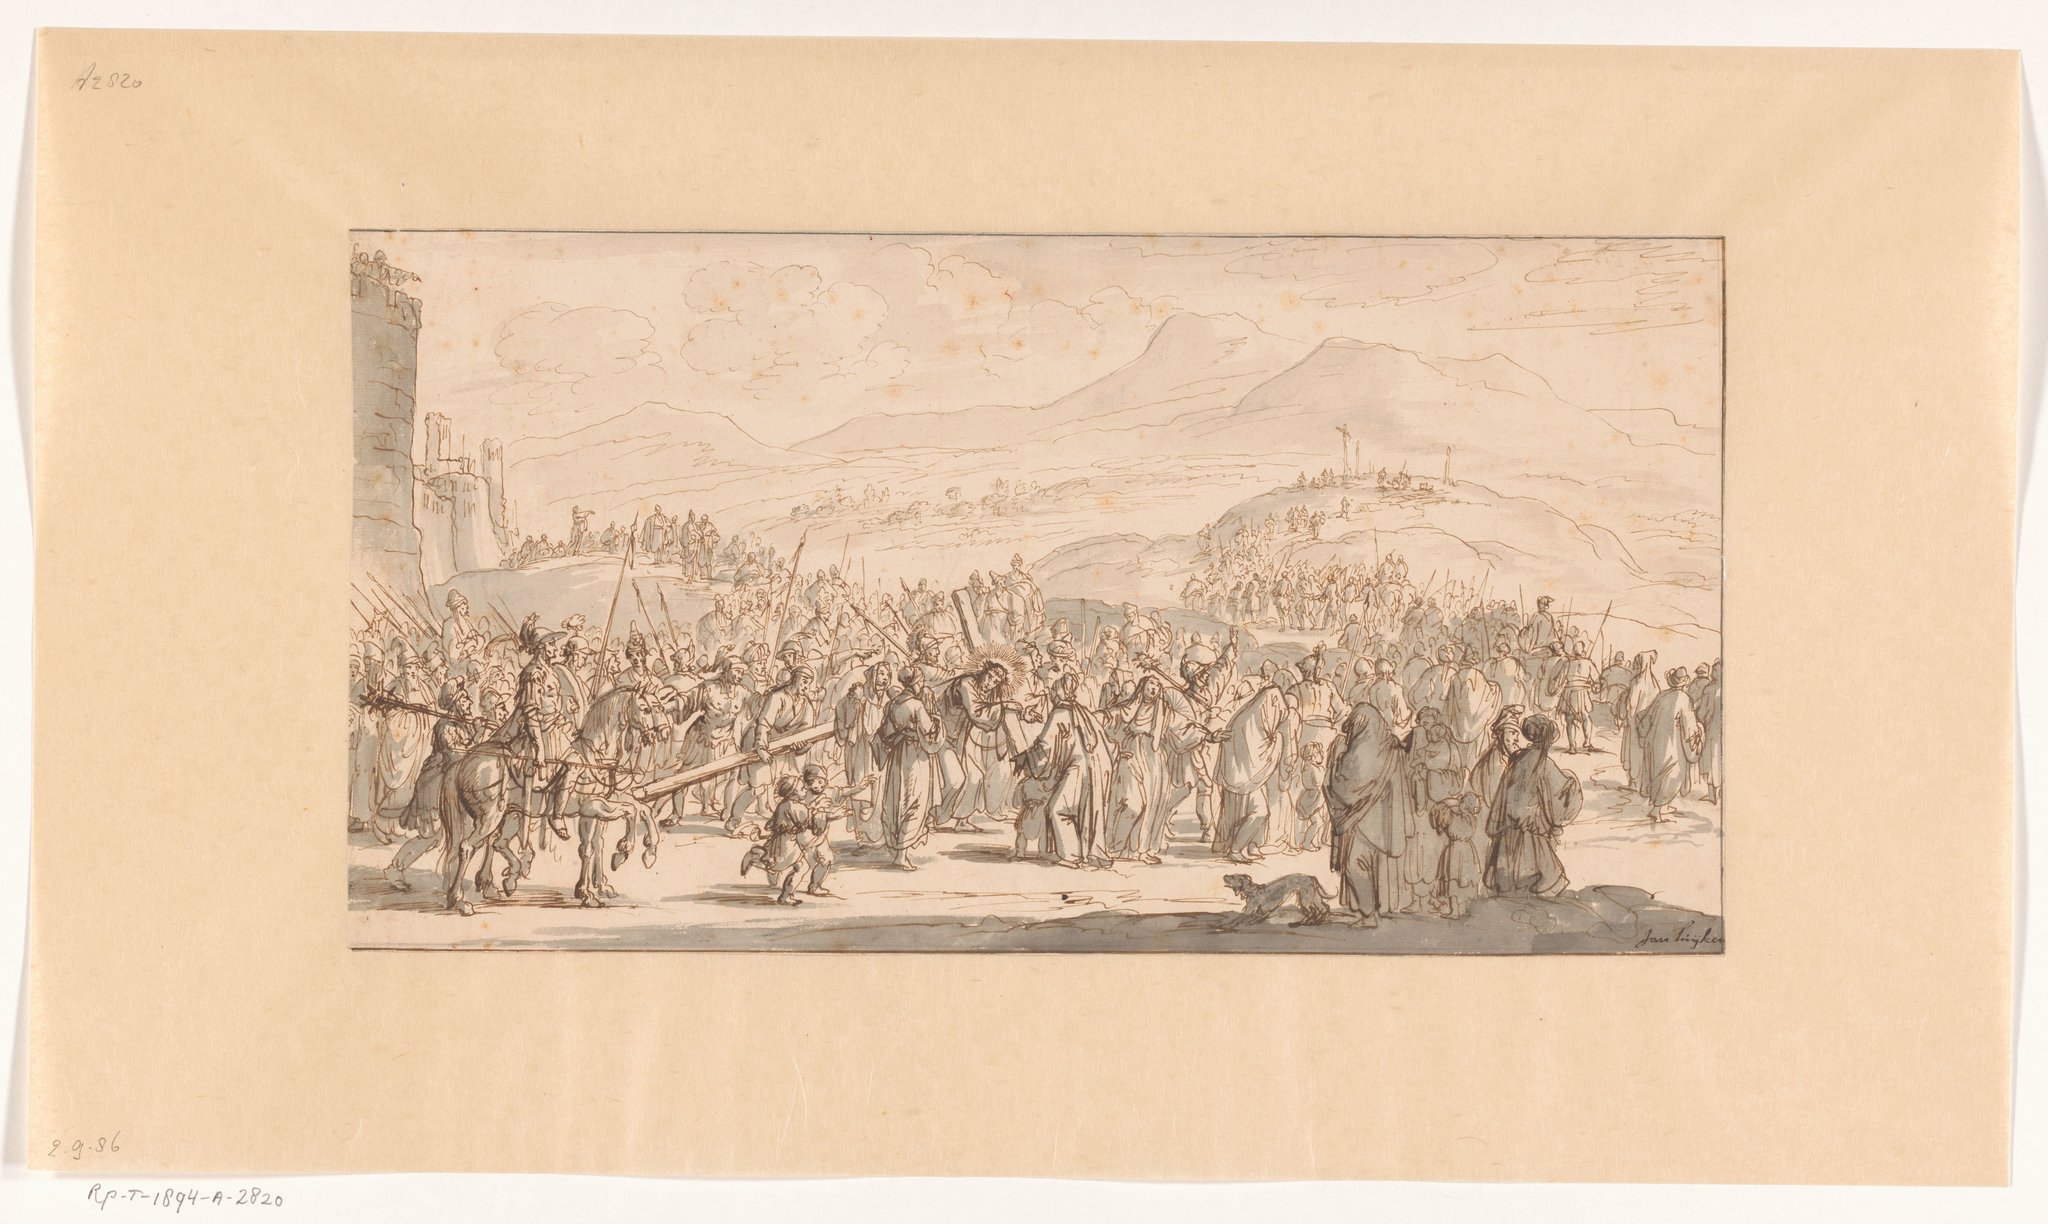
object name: drawing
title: De kruisdraging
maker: jan luyken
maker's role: draughtsman, print maker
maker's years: 1649-1712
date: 1659-1712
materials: ink, paper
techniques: brush, pen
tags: carrying of the cross: christ bearing the cross, alone or with the help of others (e.g. simon the cyrenian)